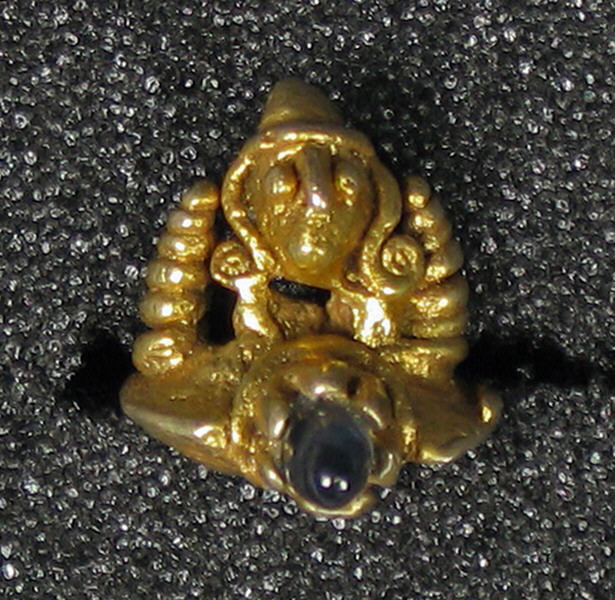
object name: earring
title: Earring, End Projections and Gem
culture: indonesian, central java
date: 701-1200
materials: gold